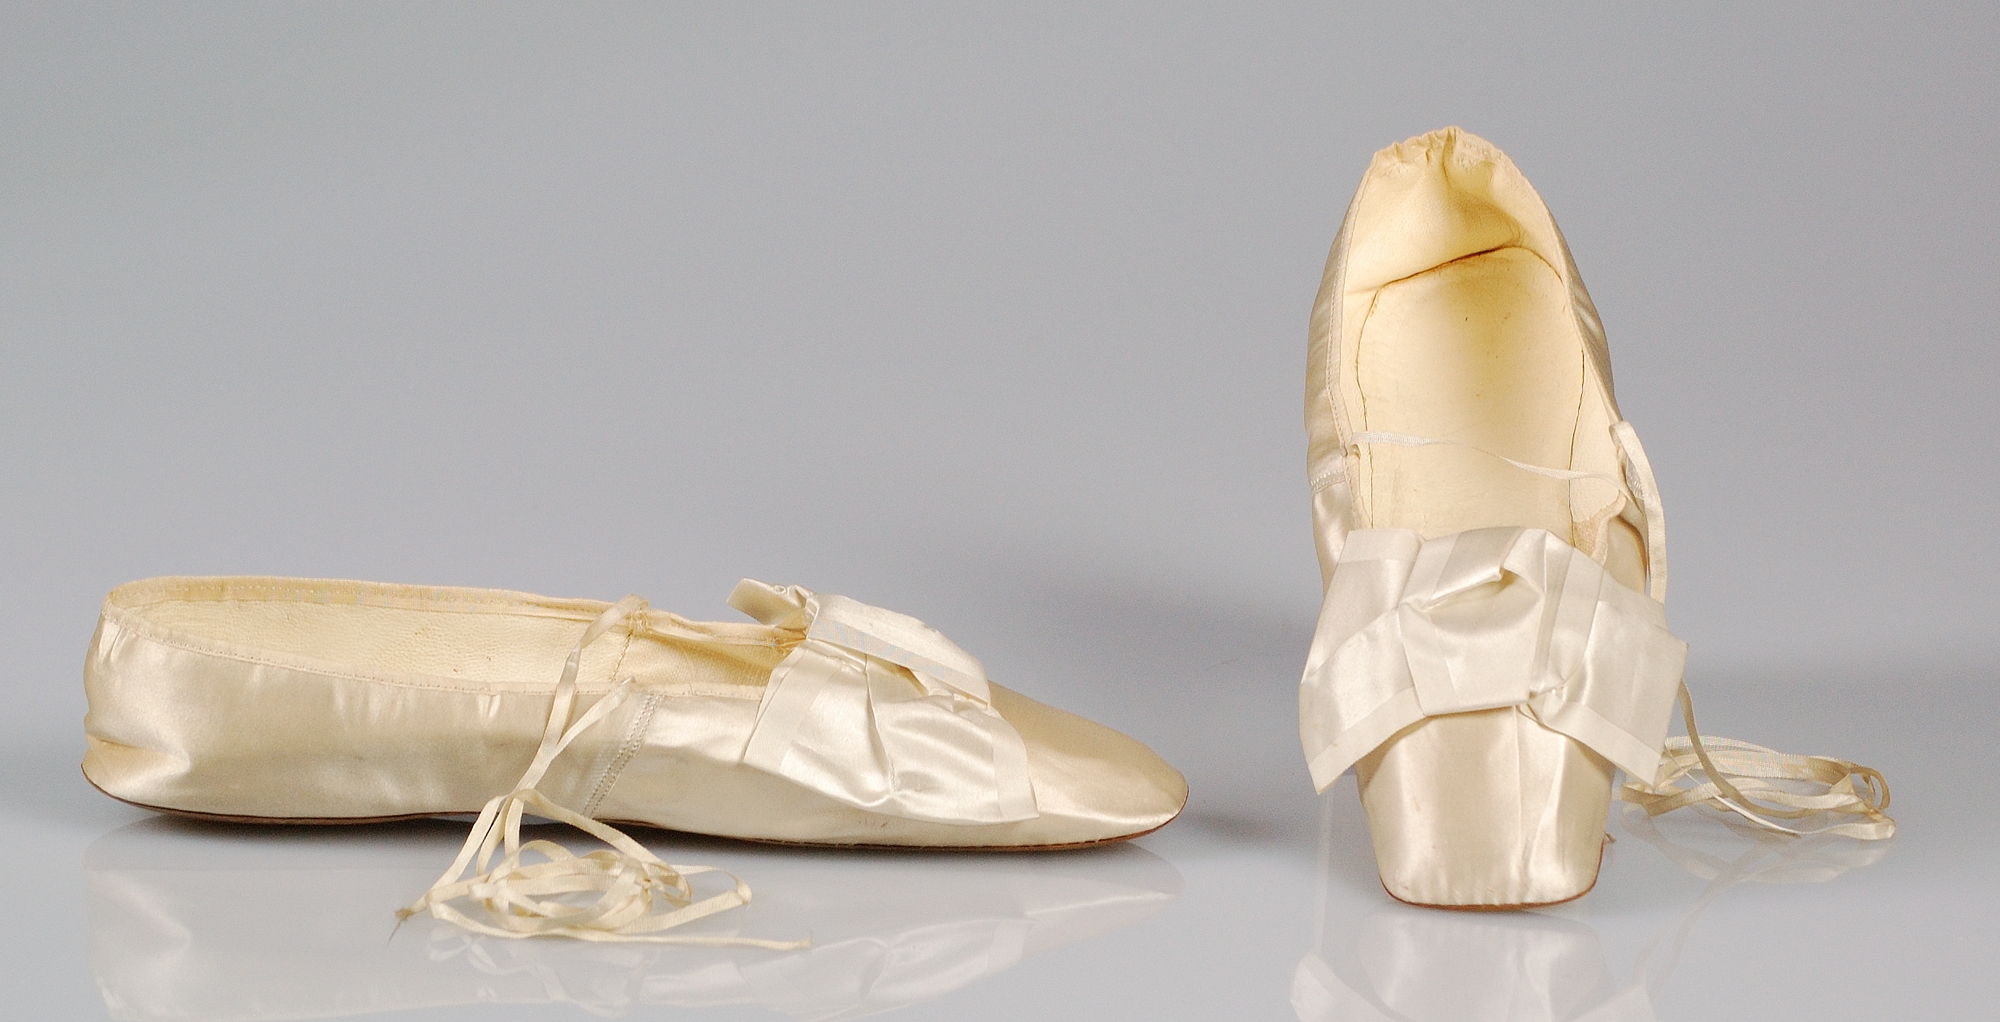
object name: evening slipper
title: Evening slippers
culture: french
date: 1845-1865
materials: silk